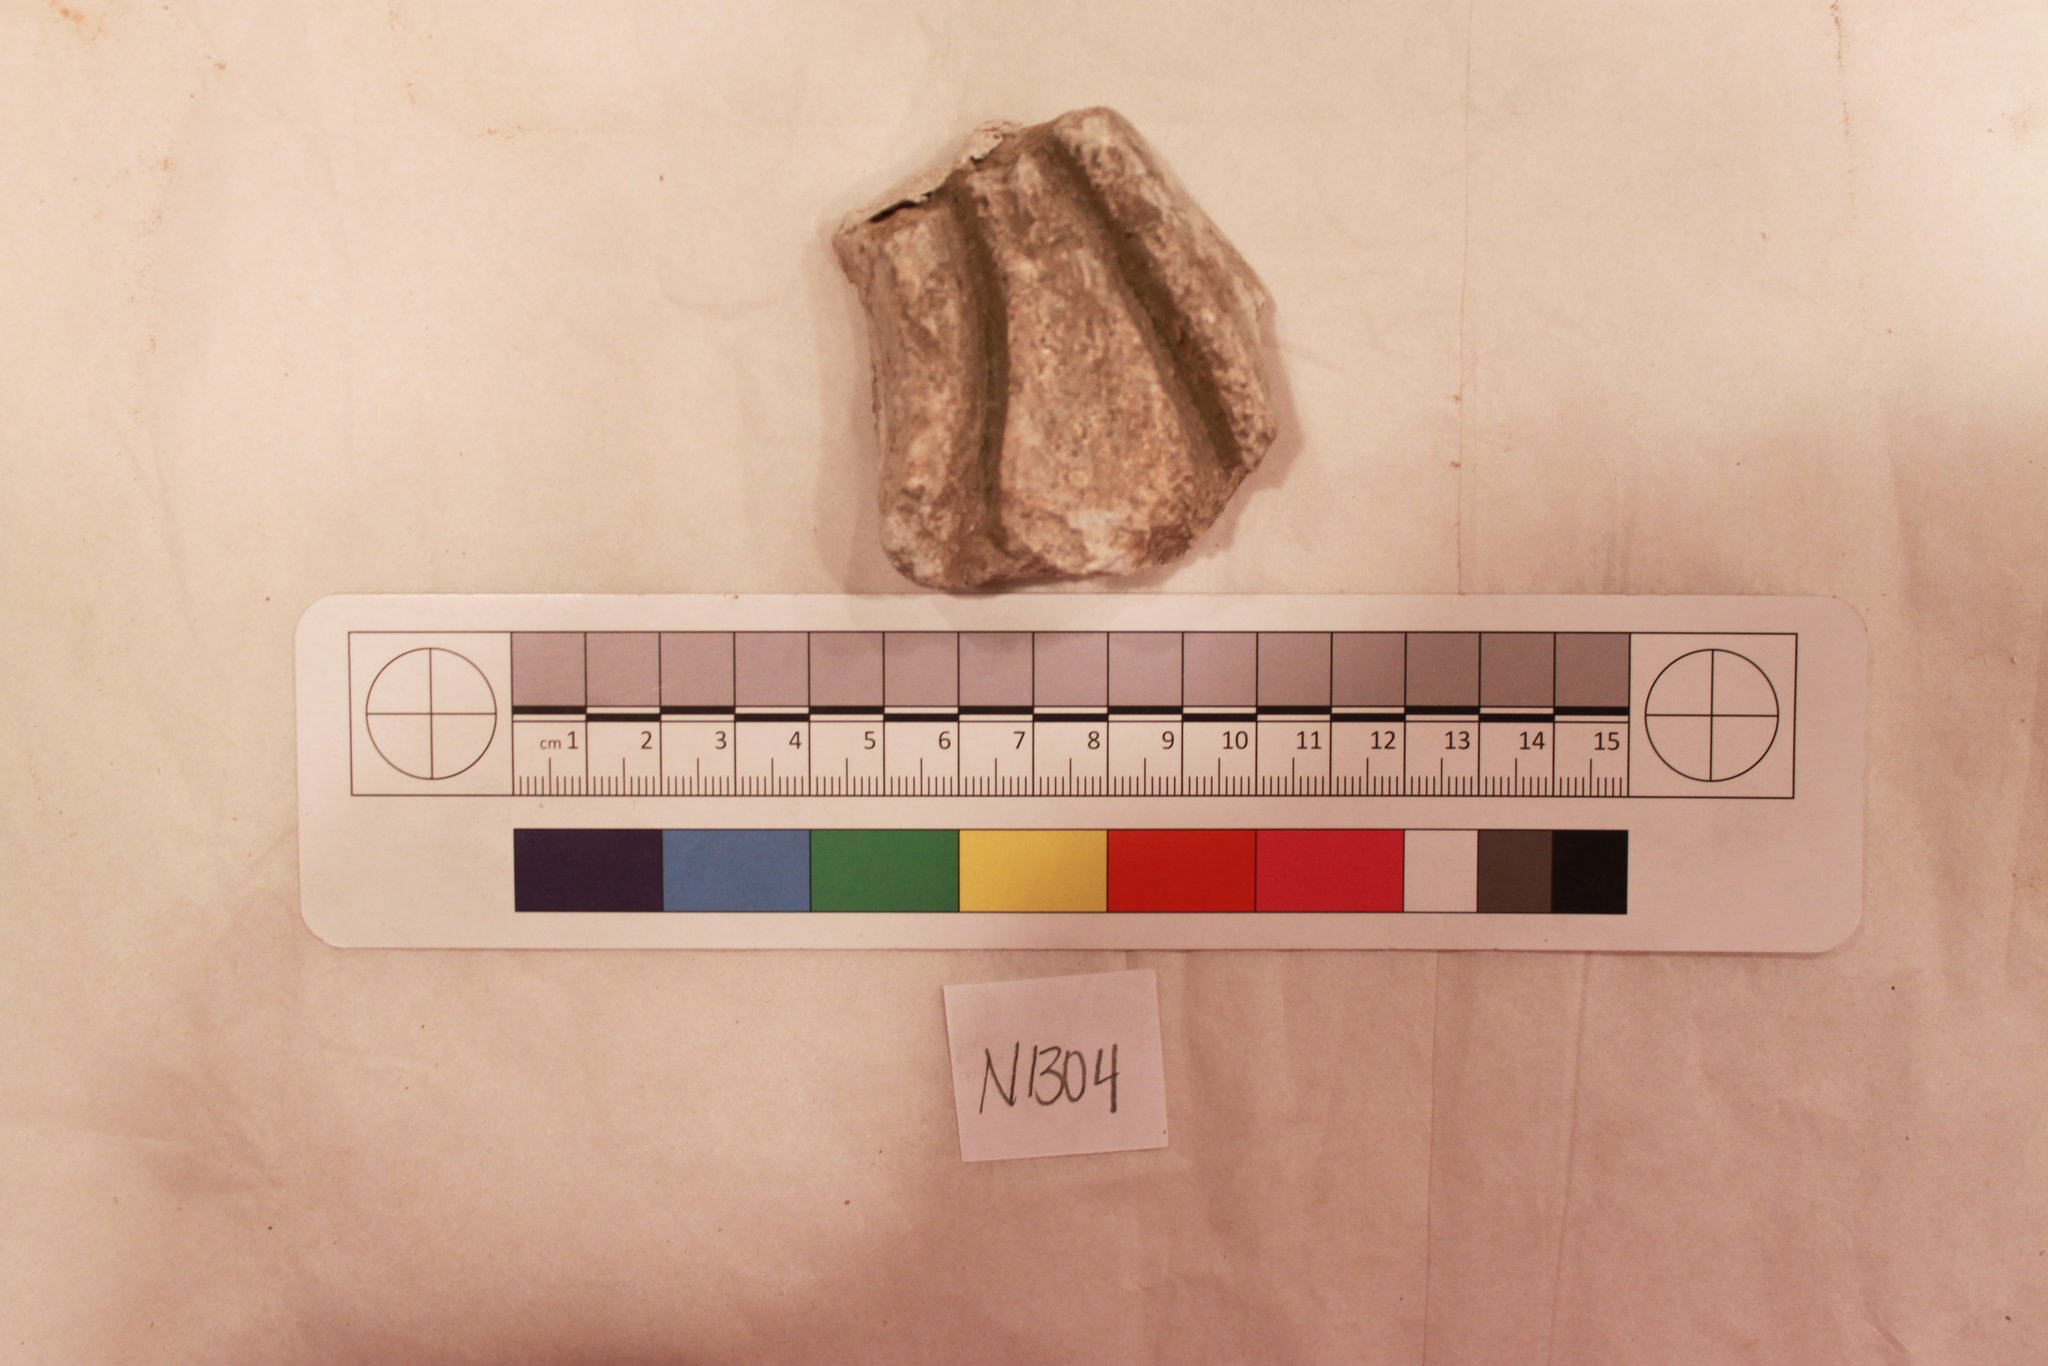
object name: fragment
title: Stucco Fragment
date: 701-1200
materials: plaster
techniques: carving, painting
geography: iran